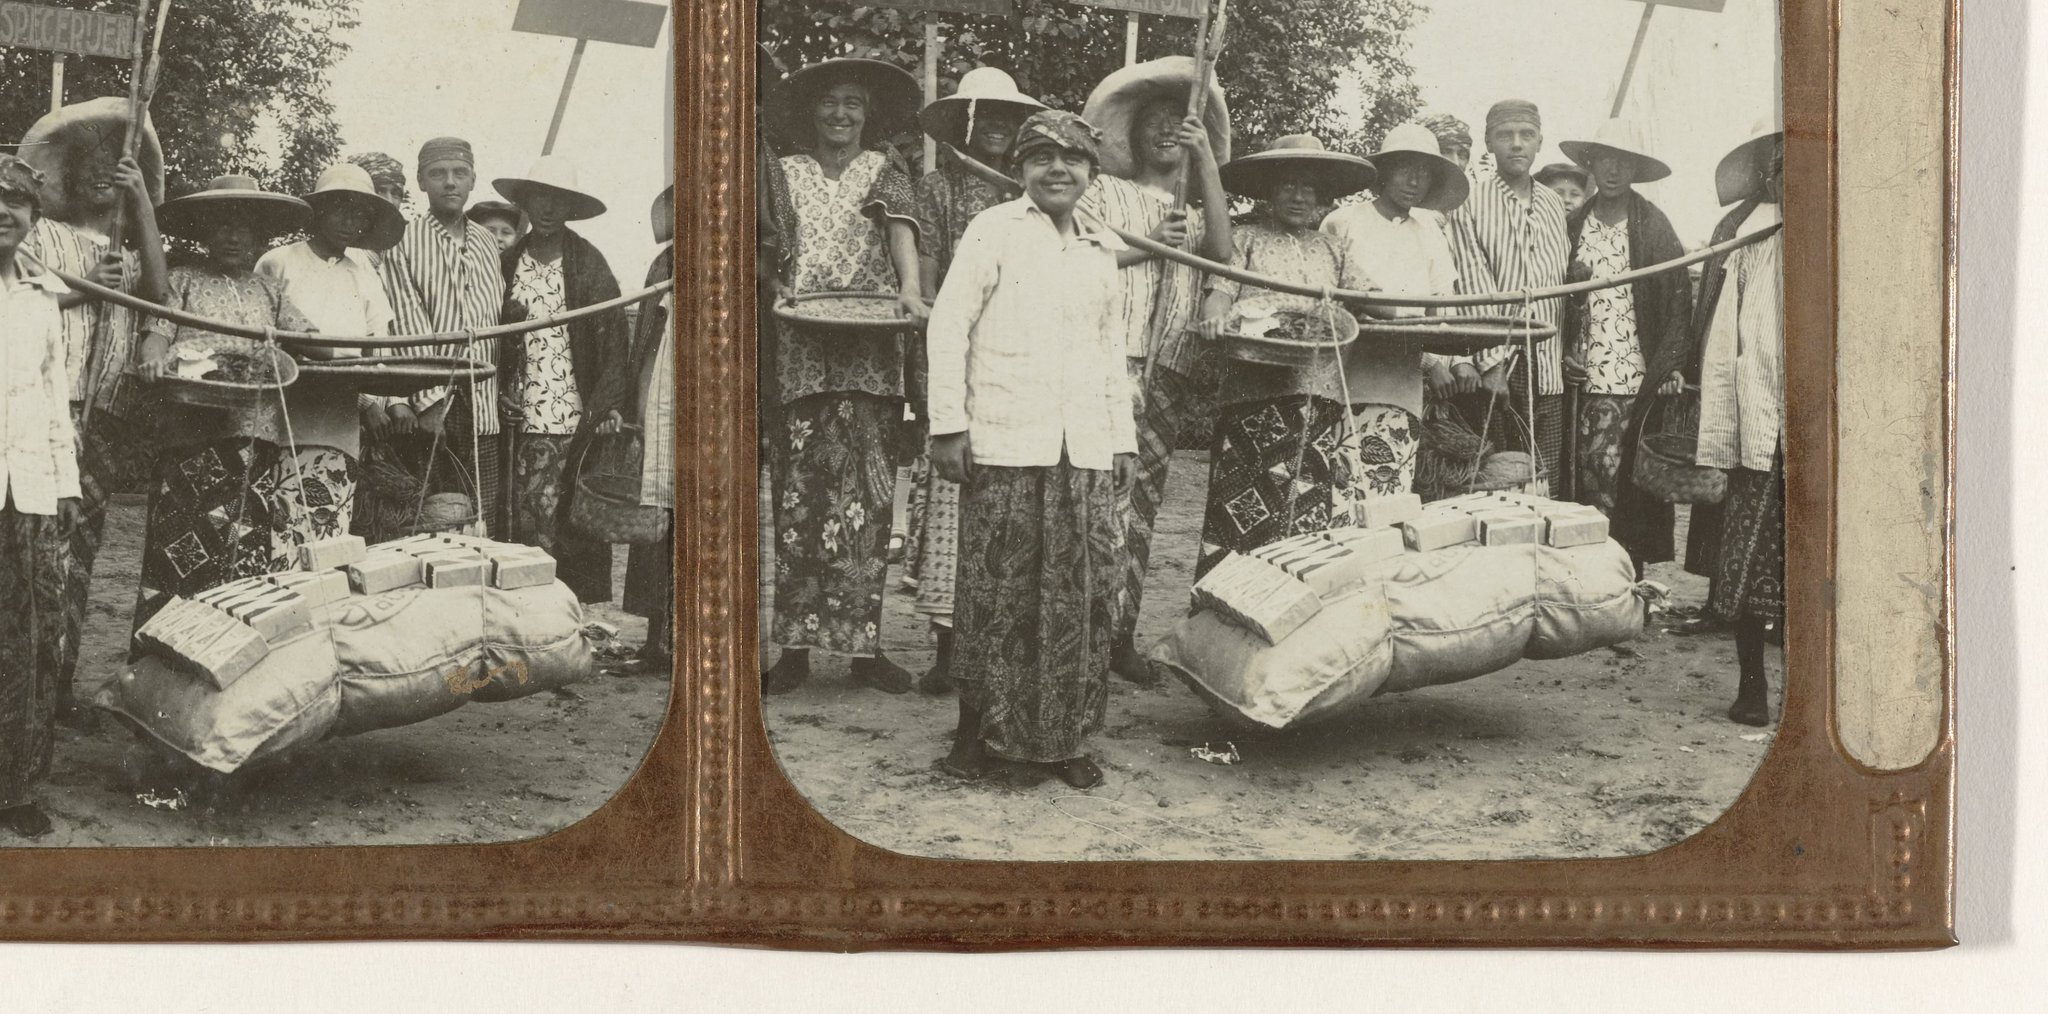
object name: stereograph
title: A Group of Europeans Dressed Up, Their Faces Possibly Painted to Resemble Indonesians, Carrying Spices and Other Colonial Goods on a Shoulder Pole and in Flat Baskets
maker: Anonymous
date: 1898-1935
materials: cardboard, copper, photographic support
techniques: gelatin silver print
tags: seasonings, spices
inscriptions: number: ‘Ro 160866’